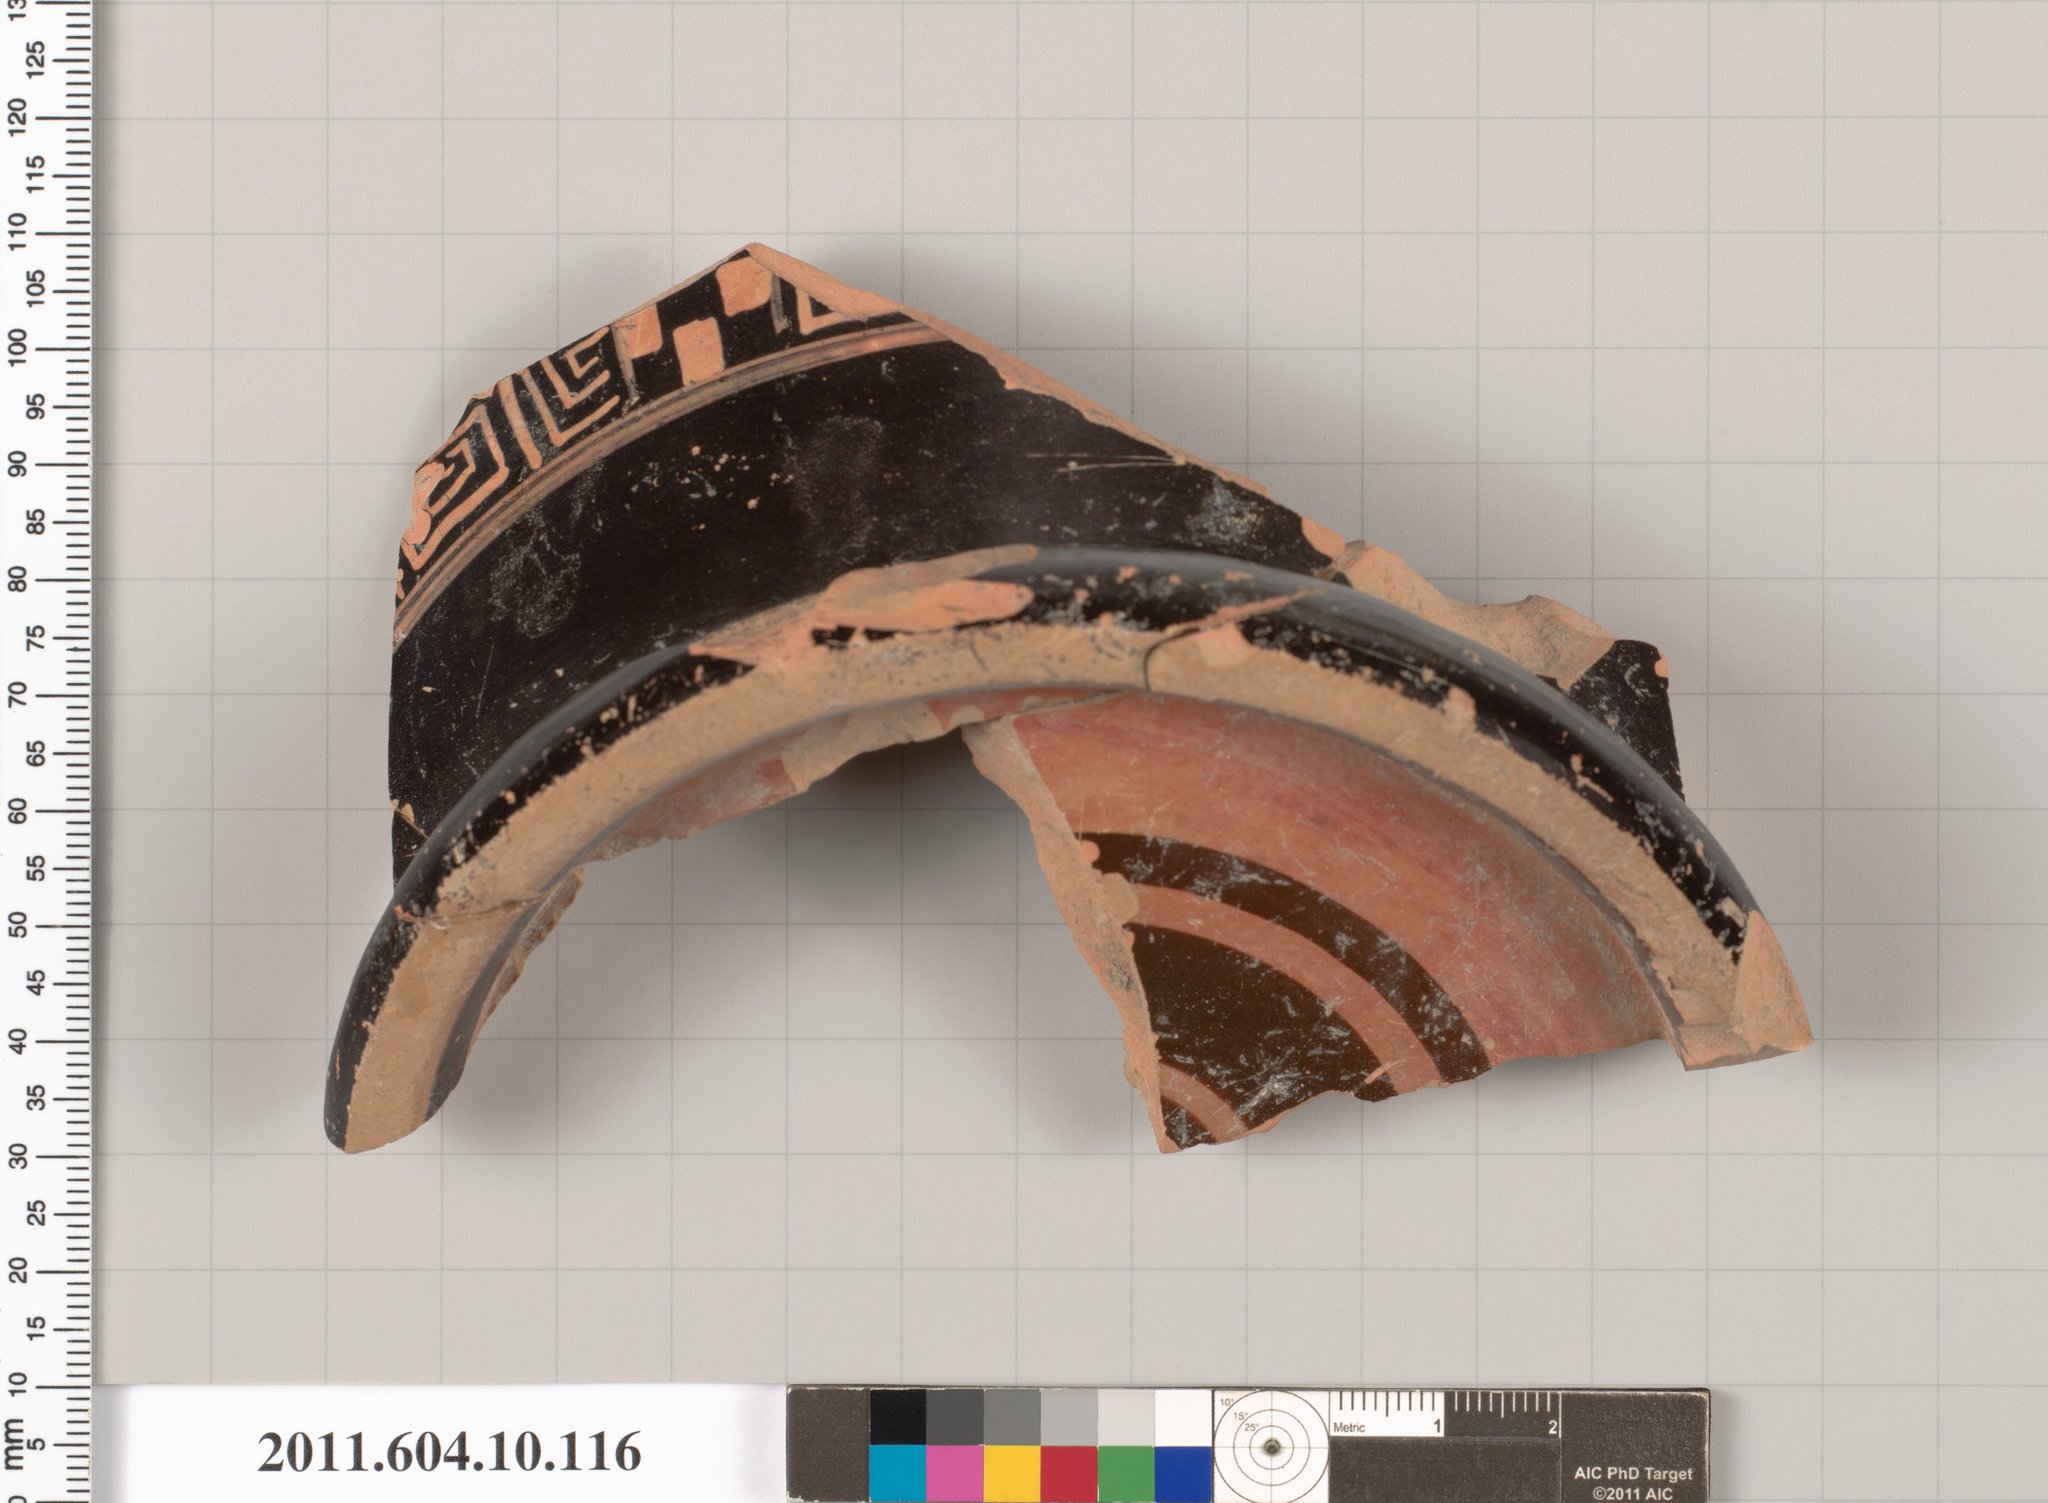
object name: skyphos fragment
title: Terracotta rim fragment of a skyphos (deep drinking cup)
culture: etruscan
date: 434-368 BCE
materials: terracotta